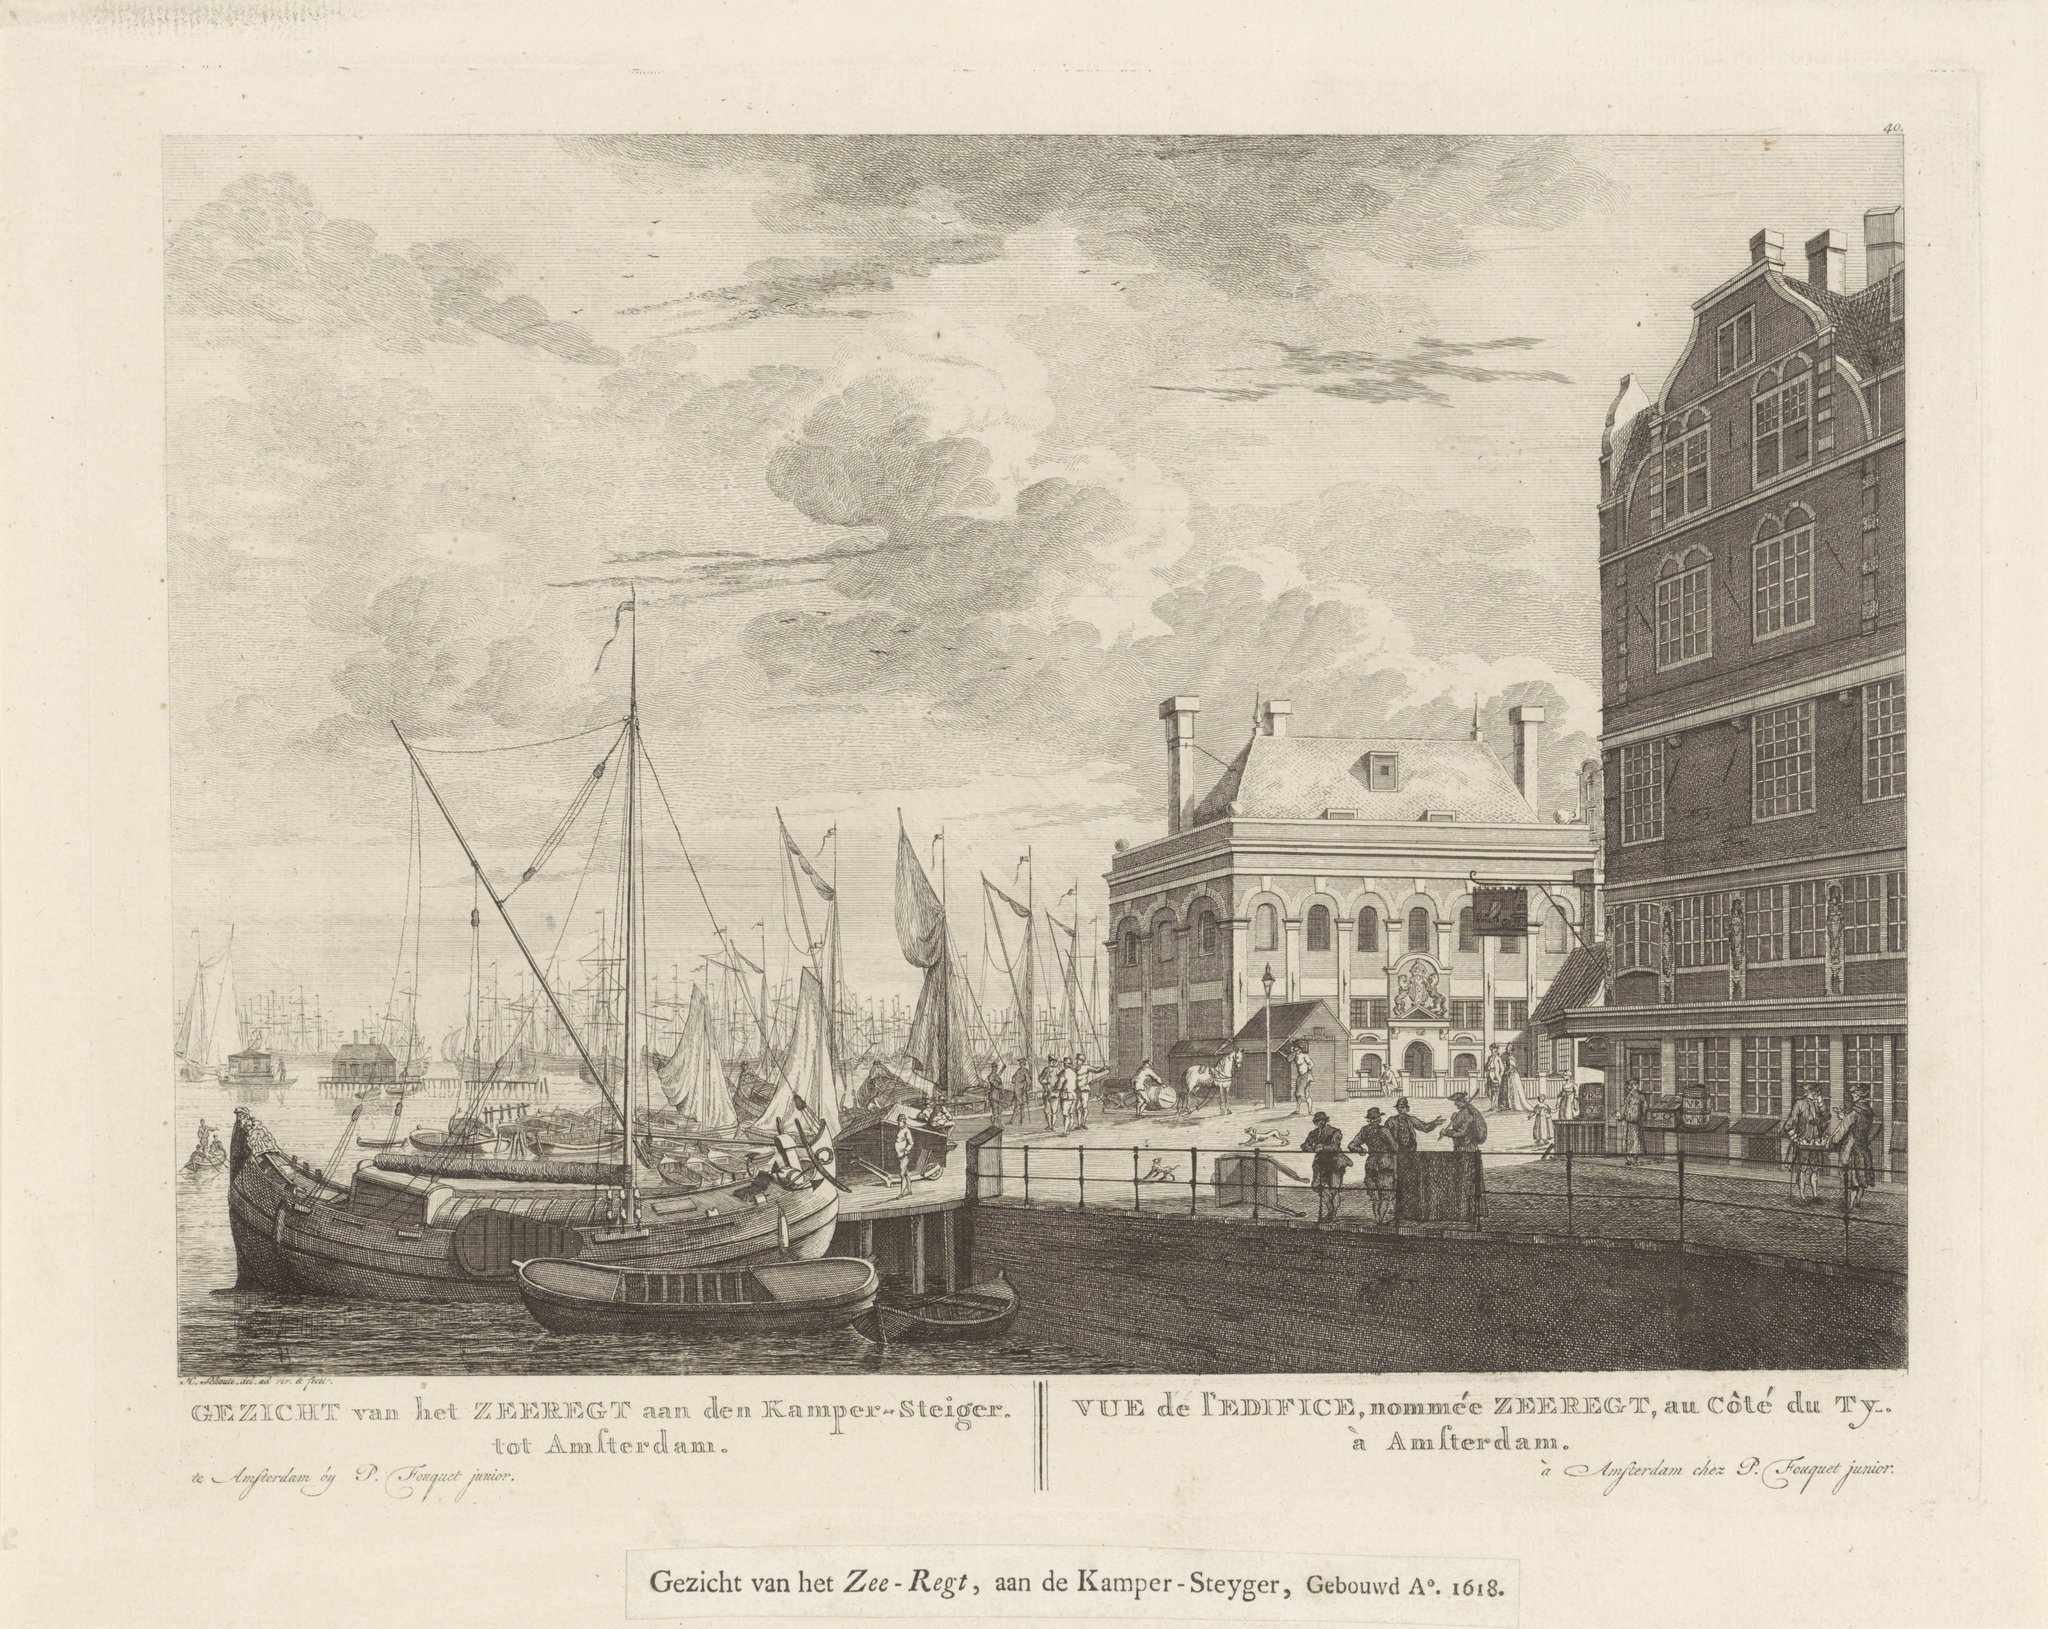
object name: print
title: Gezicht van het Zeeregt aan den Kamper-Steiger. Tot Amsterdam / Vue de l'edifice, nommée Zeeregt, au côté du Ty. À Amsterdam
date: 1770-1783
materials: paper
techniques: engraving, etching, letterpress printing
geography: amsterdam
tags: harbour, court building, canals, waters (in city) (+ city(-scape) with figures, staffage), street (+ city(-scape) with figures, staffage)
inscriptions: inscription, collector's mark: Lugt 2228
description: Deze prent is ook gebruikt in de zogenaamde Atlas van Fouquet.* Pierre Fouquet gaf vanaf 1760 stadsgezichten van Amsterdam - naar tekeningen van verschillende kunstenaars, gemaakt door verschillende prentmakers - uit. Deze prenten werden aanvankelijk los of in series verkocht. Zoals toen gebruikelijk kon de koper de prenten zelf laten inbinden. Hiertoe gaf Fouquet tussen 1778 en 1783 een titelblad, plattegrond en inhoudsopgave van de tot dusver 100 uitgegeven prenten uit (1). Gezien de inhoud afhankelijk was van wat de koper had verzameld verschilt de inhoud van de verschillende bewaarde Fouquetatlassen onder deze titel sterk. Ook zijn er exemplaren bekend waar tevens andere prenten aan zijn toegevoegd. Omdat er behoefte bleek aan uitleg bij de platen werd in 1783 een nieuwe versie van de atlas uitgegeven, aangevuld met tekst en twee prenten. De aangegeven volgorde veranderde maar de platen van de al eerder uitgegeven prenten bleven ongewijzigd. Deze uitgave werd in opdracht van Fouquet gedrukt bij Daniël Jean Changuion en Petrus den Hengst (2). Een tiental platen werd bijgewerkt en verscheen, met nieuw impressum, in het vervolg van Wagenaars geschiedenis van Amsterdam, uitgeven door Petrus Conradi en Folkert van der Plaats (3). Een aantal jaar na het overlijden van Fouquet kwam Evert Maaskamp met een nieuwe uitgave van de atlas, met verbeterde tekst en toevoeging van twee prenten. Op alle platen verwijderde hij het oude en liet hij zijn eigen impressum zetten (4). De huidige staat van de prent komt voor in exemplaren van de onder (1) en (2) genoemde werken. * Onder de Atlas van Fouquet of Fouquetatlas verstaan we de hieronder vermelde publicaties (1), (2) en (4). (1). Afbeeldingen van de wyd-vermaarde koopstad Amsterdam benevens des zelvs voornaamste gebouwen en gezigten alle naar het leeven getekend / Receuil des edifices les plus considerables et des plus belles vues, de la fameuse ville d'Amsterdam, dessinées d'après nature. Amsterdam: Pierre Fouquet, 1778-1783. (2). Nieuwe atlas, van de voornaamste gebouwen en gezigten der stad Amsterdam, met derzelver beknopte beschryvingen. 2 delen. Amsterdam: Daniël Jean Changuion en Petrus den Hengst [in opdracht van Pierre Fouquet], 1783. (3). Stijl, Simon. Amsterdam, in zyne geschiedenissen, voorregten, koophandel, gebouwen, kerkenstaat, schoolen, schutterye, gilden en regeeringe, beschreeven. Om te dienen ten vervolge op het werk van Jan Wagenaar (…). 10 delen. Amsterdam en Harlingen: Petrus Conradi en Folkert van der Plaats, 1788-1801. (4). Nieuwe atlas, van de voornaamste gebouwen en gezigten der stad Amsterdam. Met derzelver beknopte beschryvingen. Amsterdam: Evert Maaskamp, 1805. * Het aantal vermelde staten is gebaseerd op het aantal gevonden staten. Mogelijk zijn er meer staten van deze prent. Zie RP-P-1921-290 voor eerste bekende staat. Zie RP-P-1939-804 voor derde bekende staat.